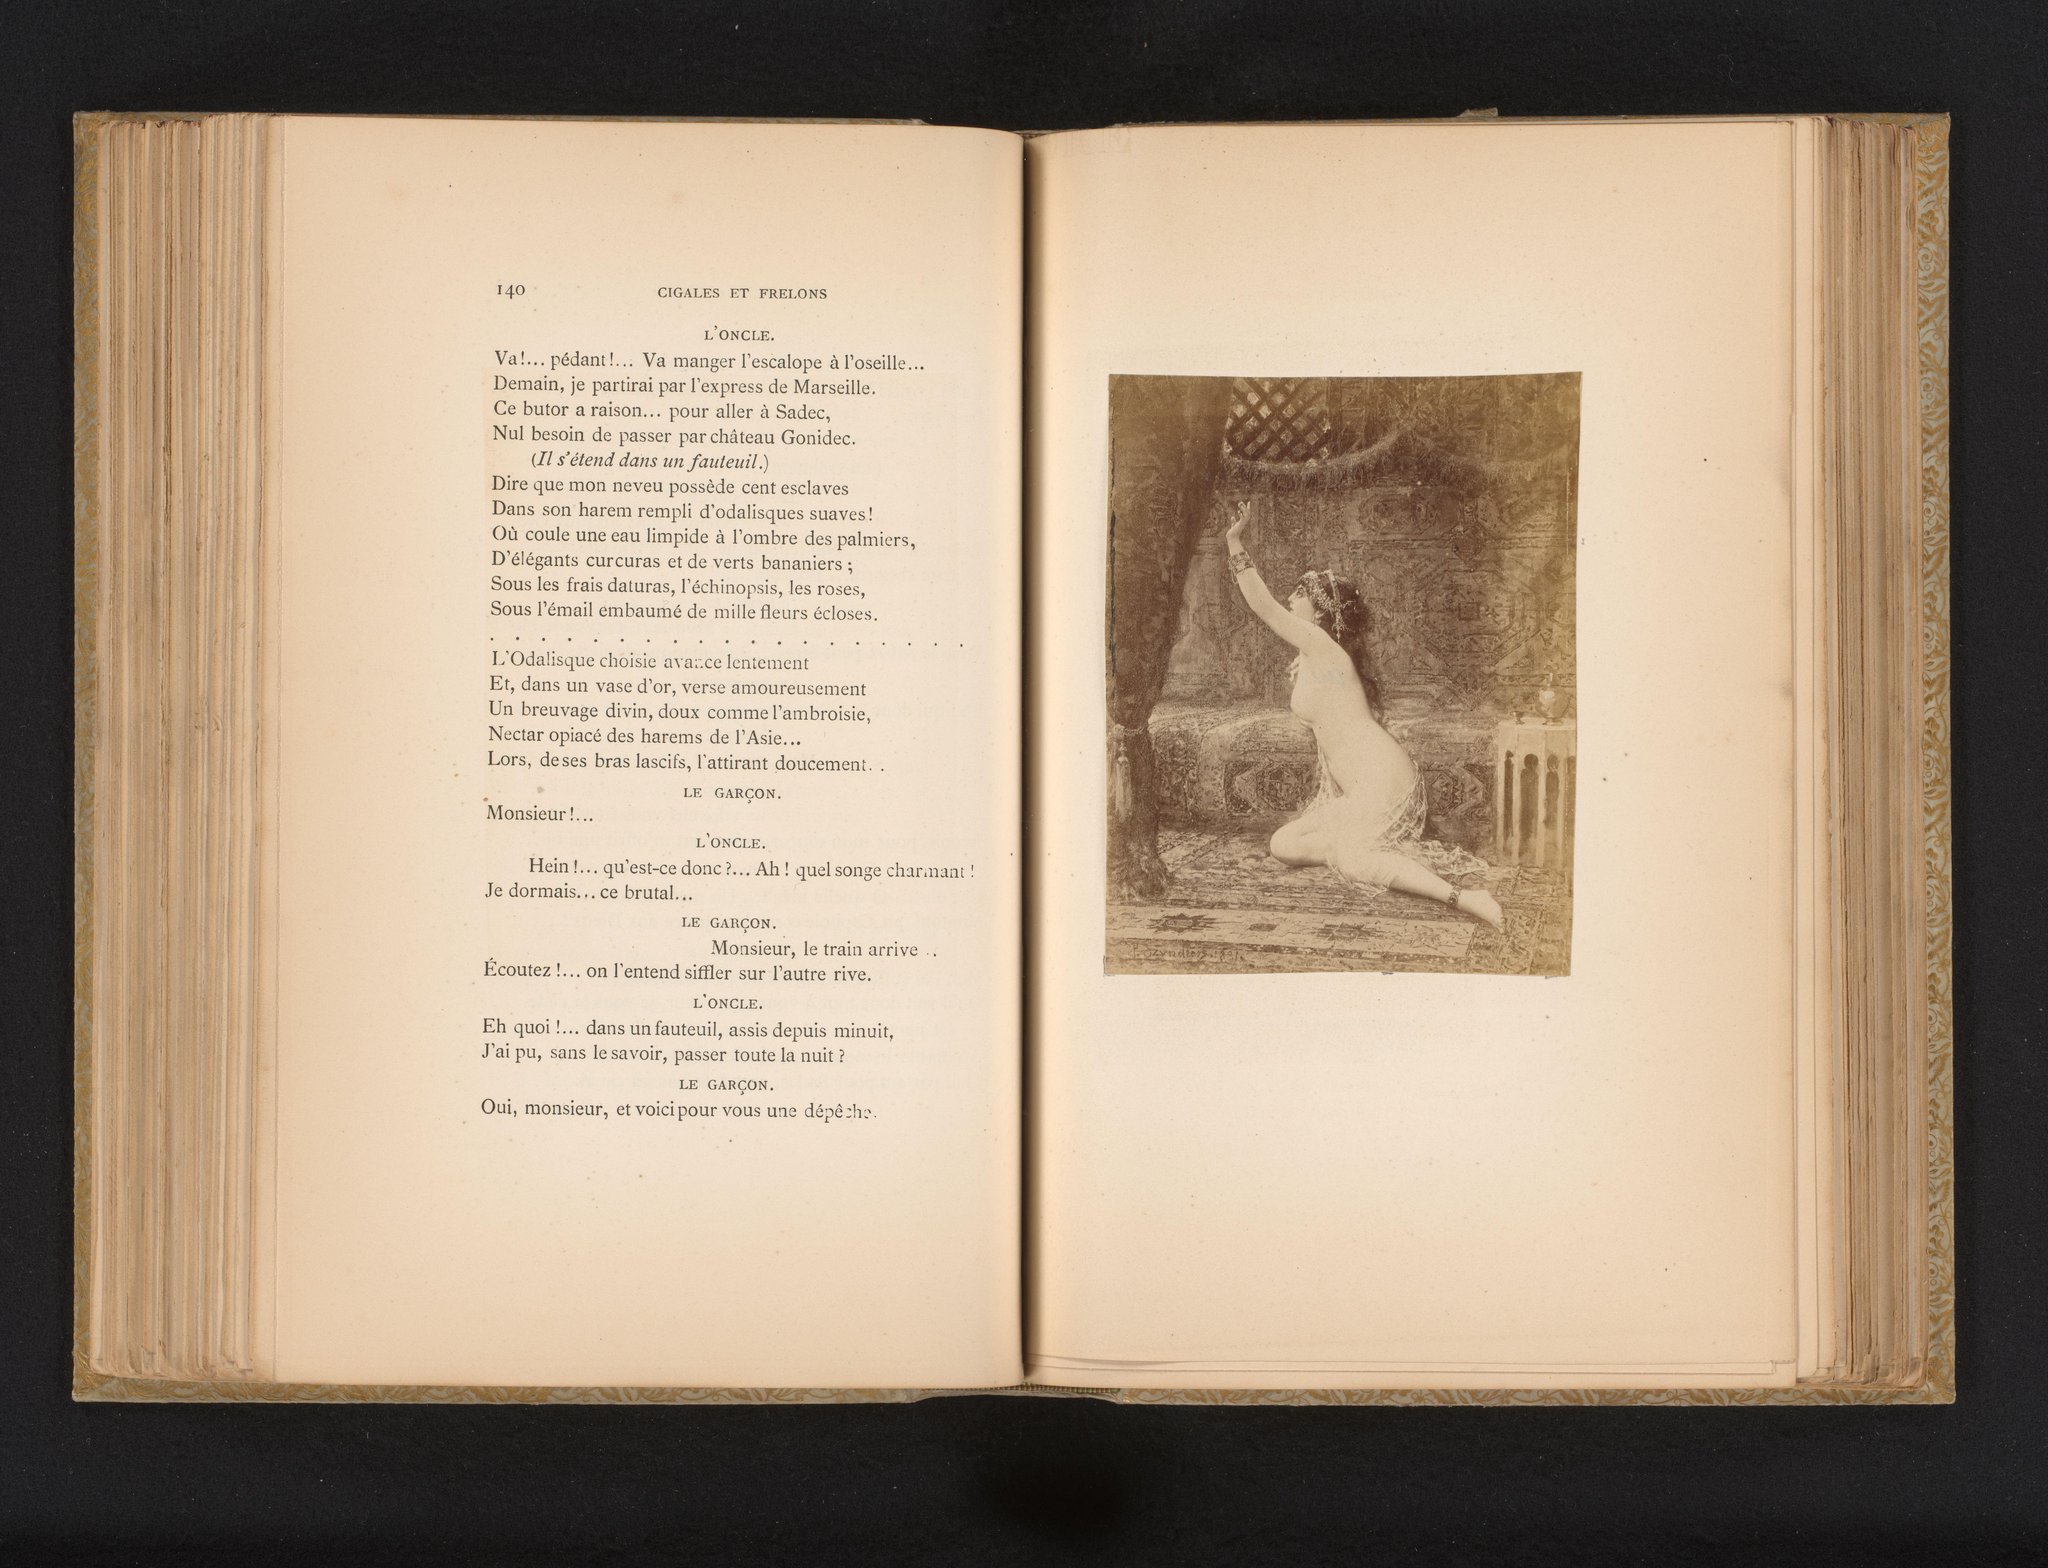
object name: photograph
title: Fotoreproductie van een schilderij van een odalisk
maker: Anonymous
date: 1874-1884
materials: paper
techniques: albumen print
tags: odalisque, picture, painting